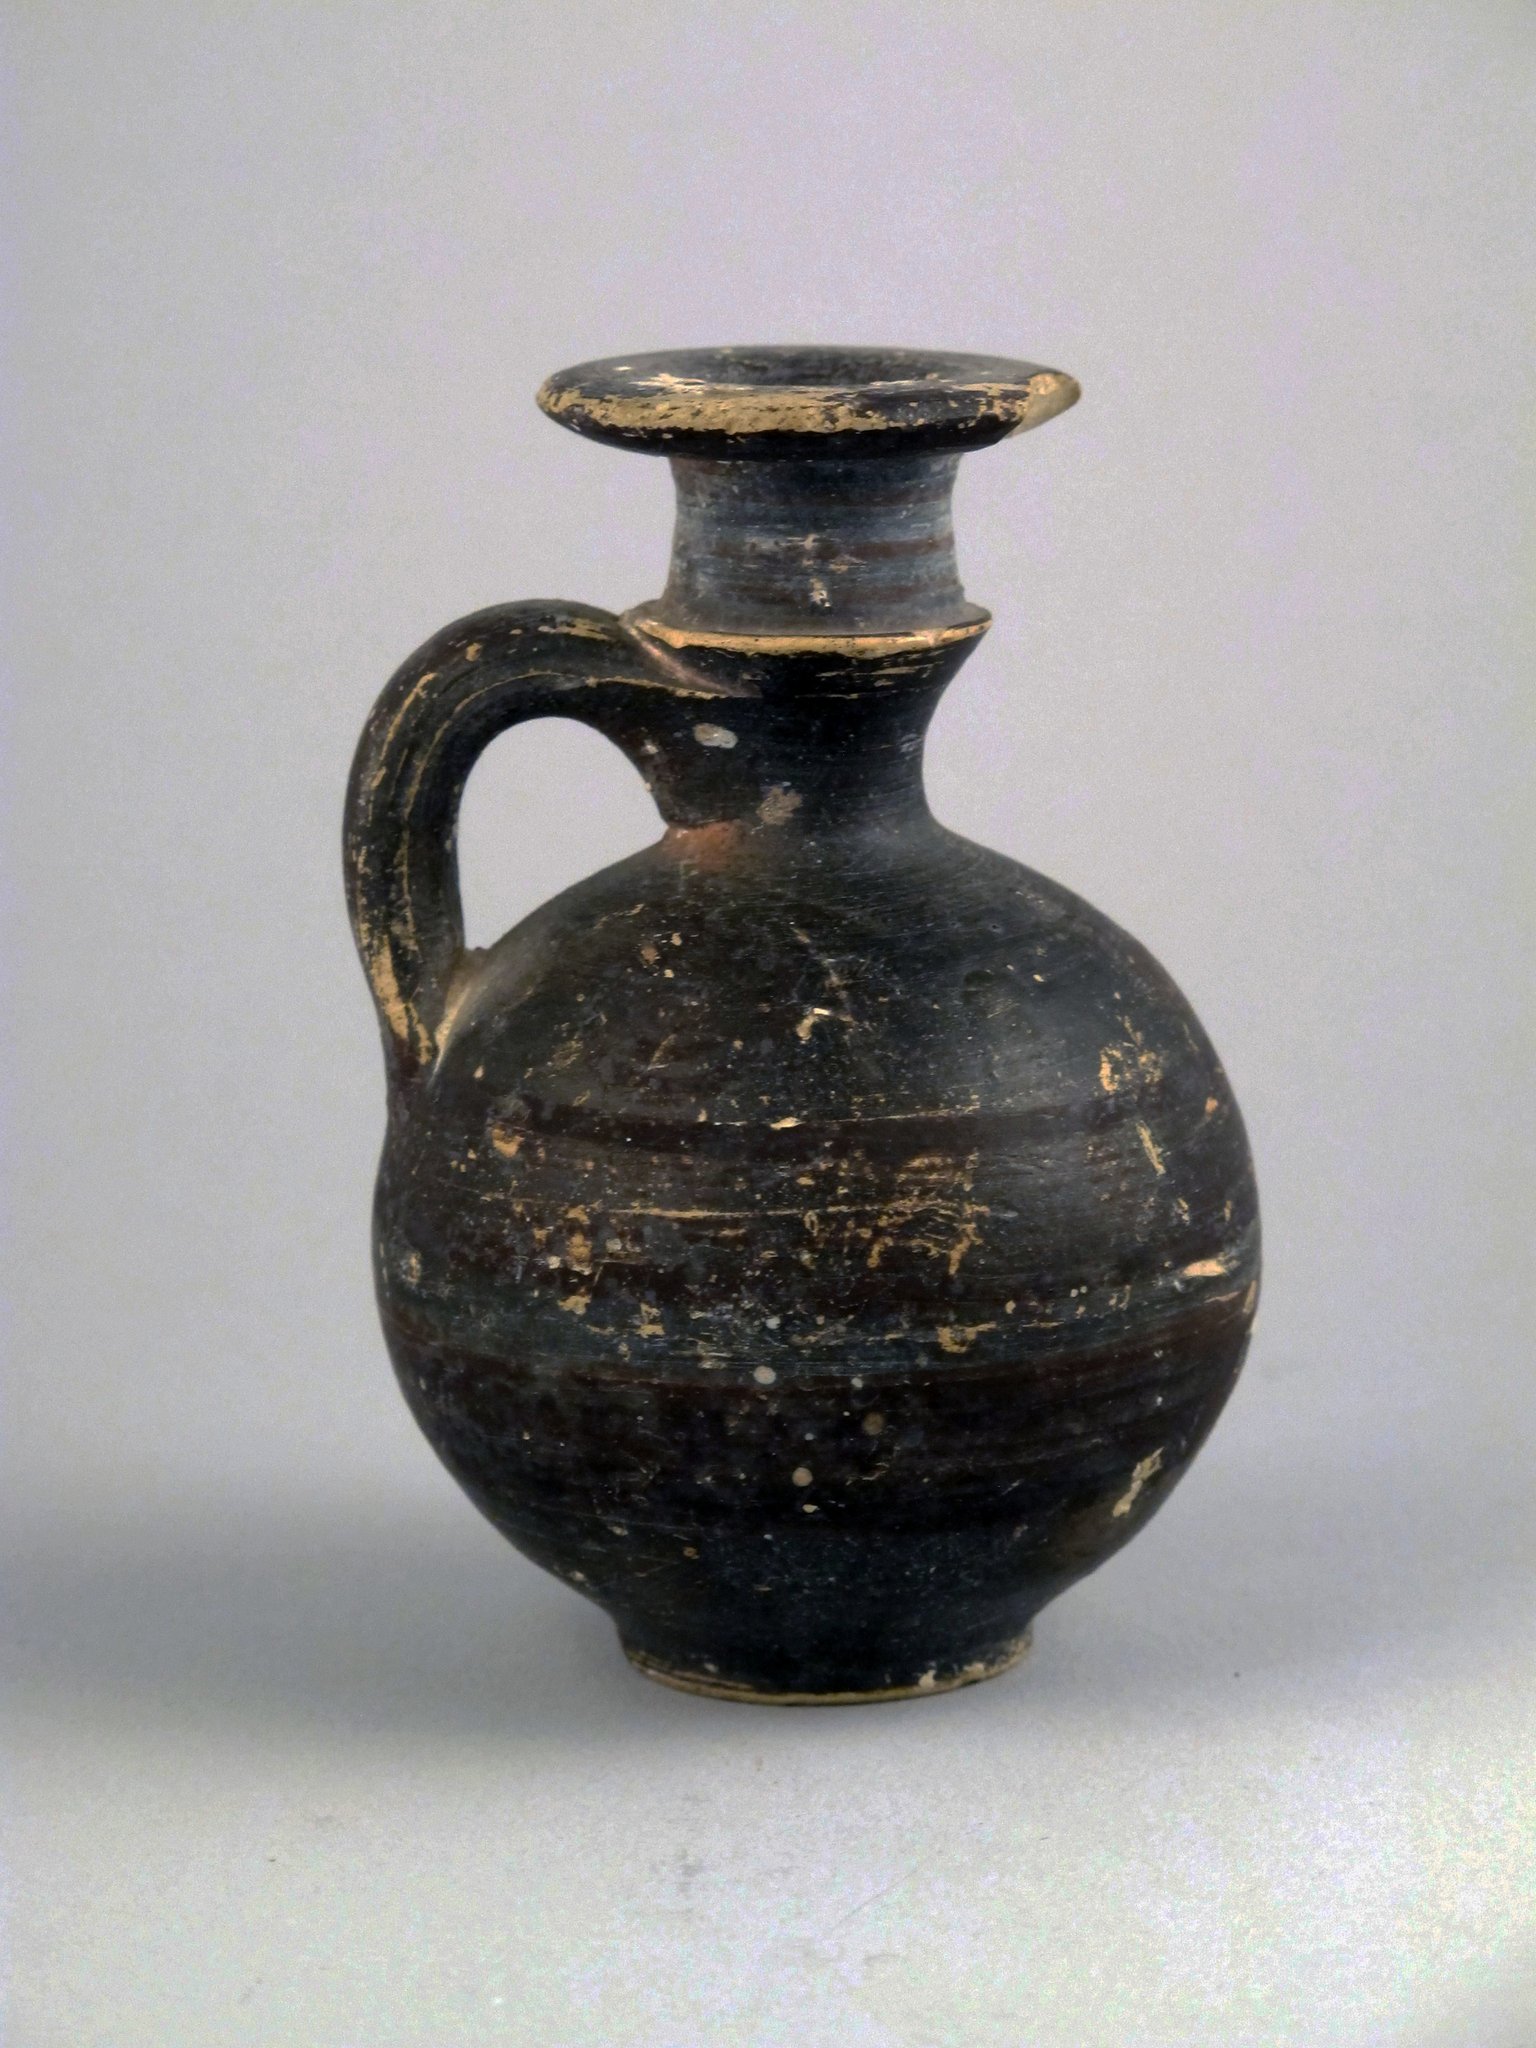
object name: juglet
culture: cypriot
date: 750-600 BCE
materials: terracotta